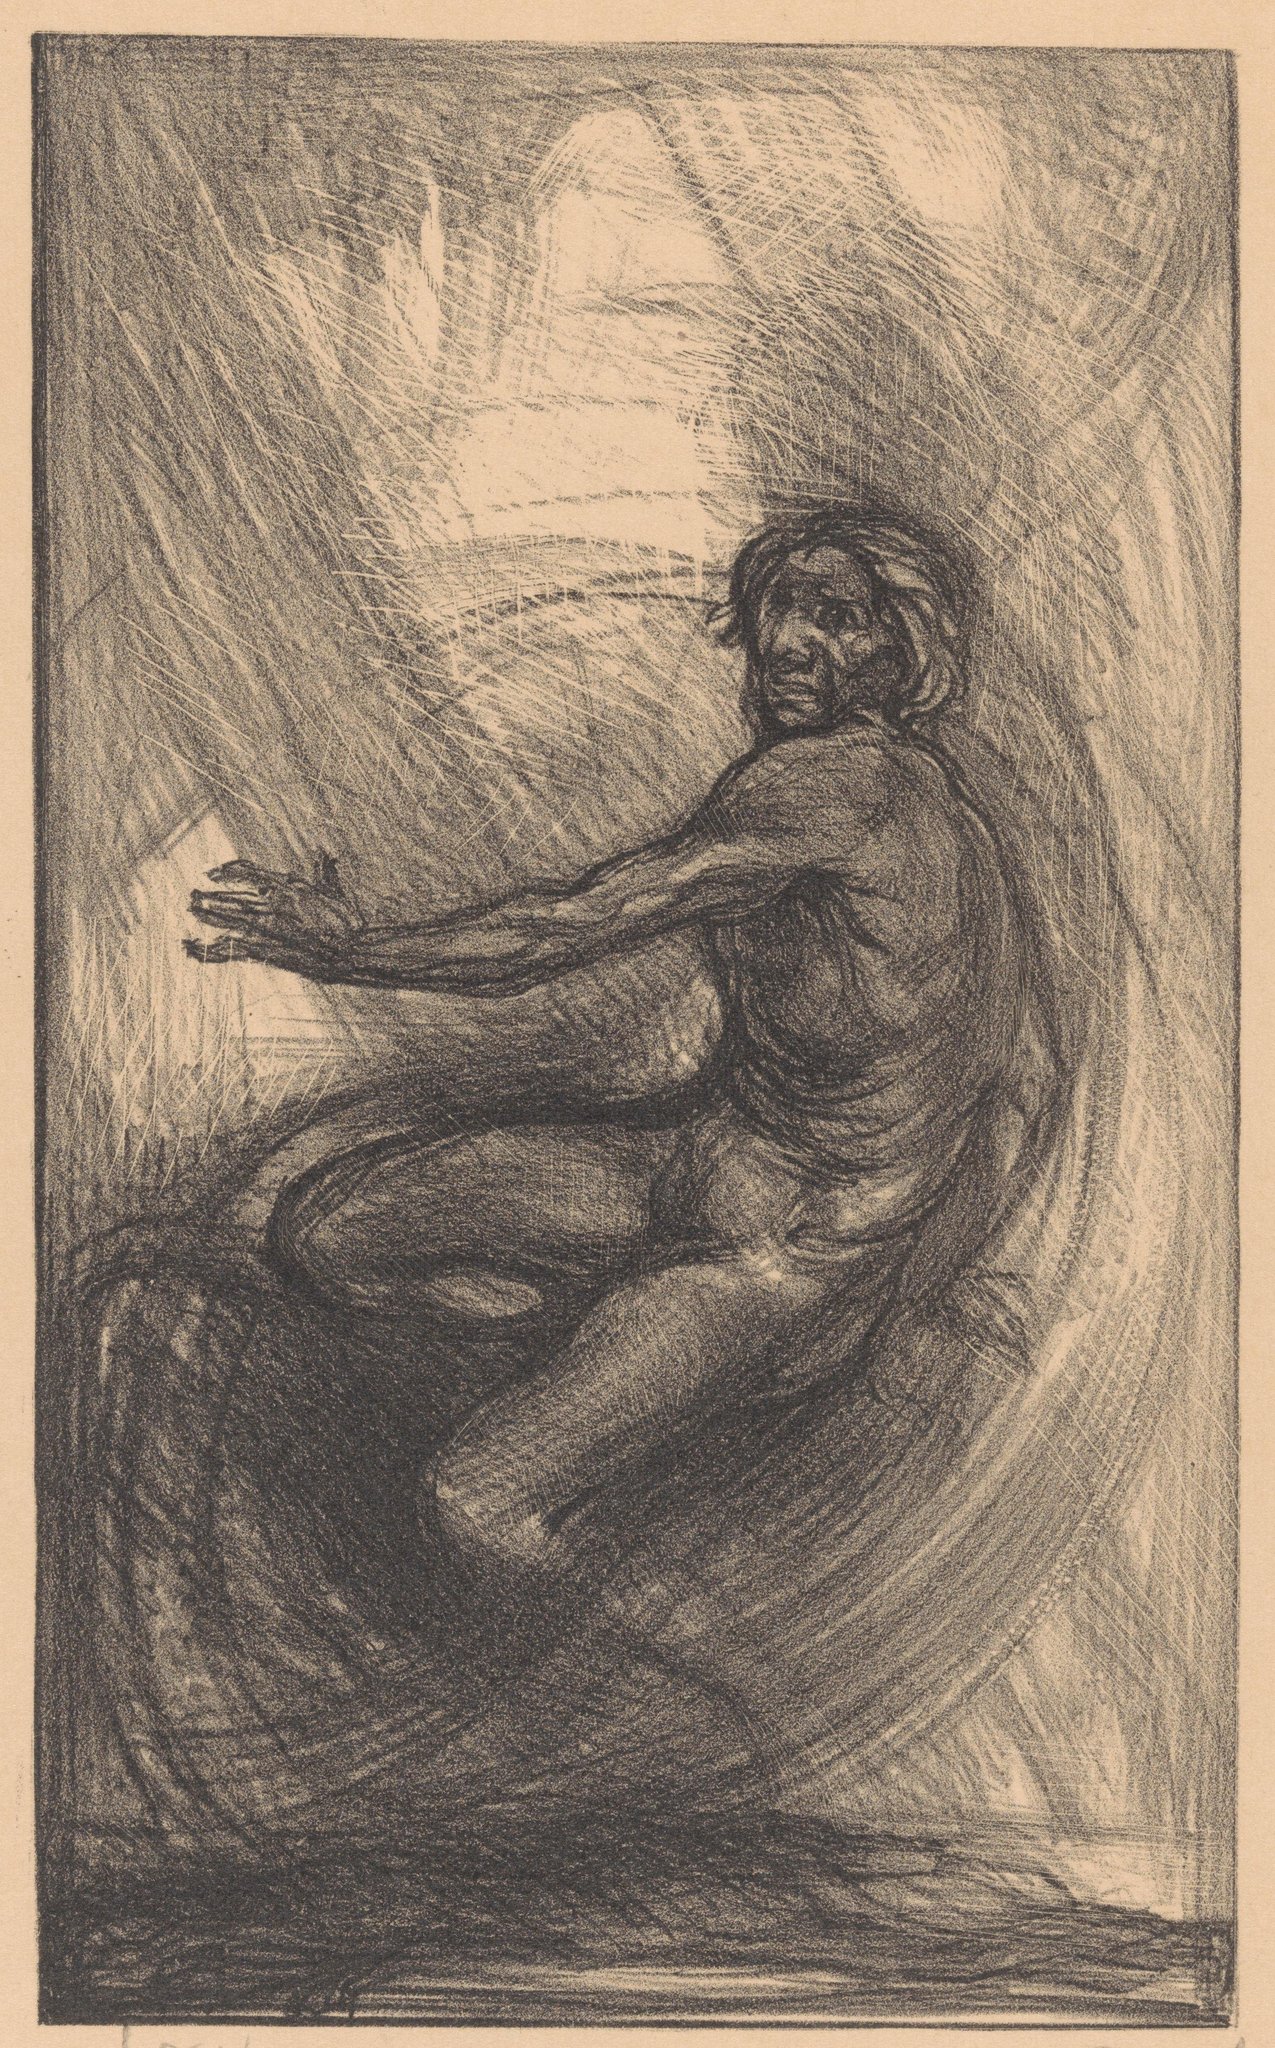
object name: print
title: Naakte man met gebogen knieën en gestrekte arm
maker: johannes josephus aarts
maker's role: draughtsman, print maker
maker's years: 1871-1934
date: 1927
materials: paper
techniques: lithograph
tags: man (showing himself) undressed, quasi-nude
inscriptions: collector's mark: Lugt 2228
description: Mogelijk een verbeelding van een scène uit het Bijbelboek Openbaring (22:8), Johannes die zich neerwerpt aan de voeten van de engel.